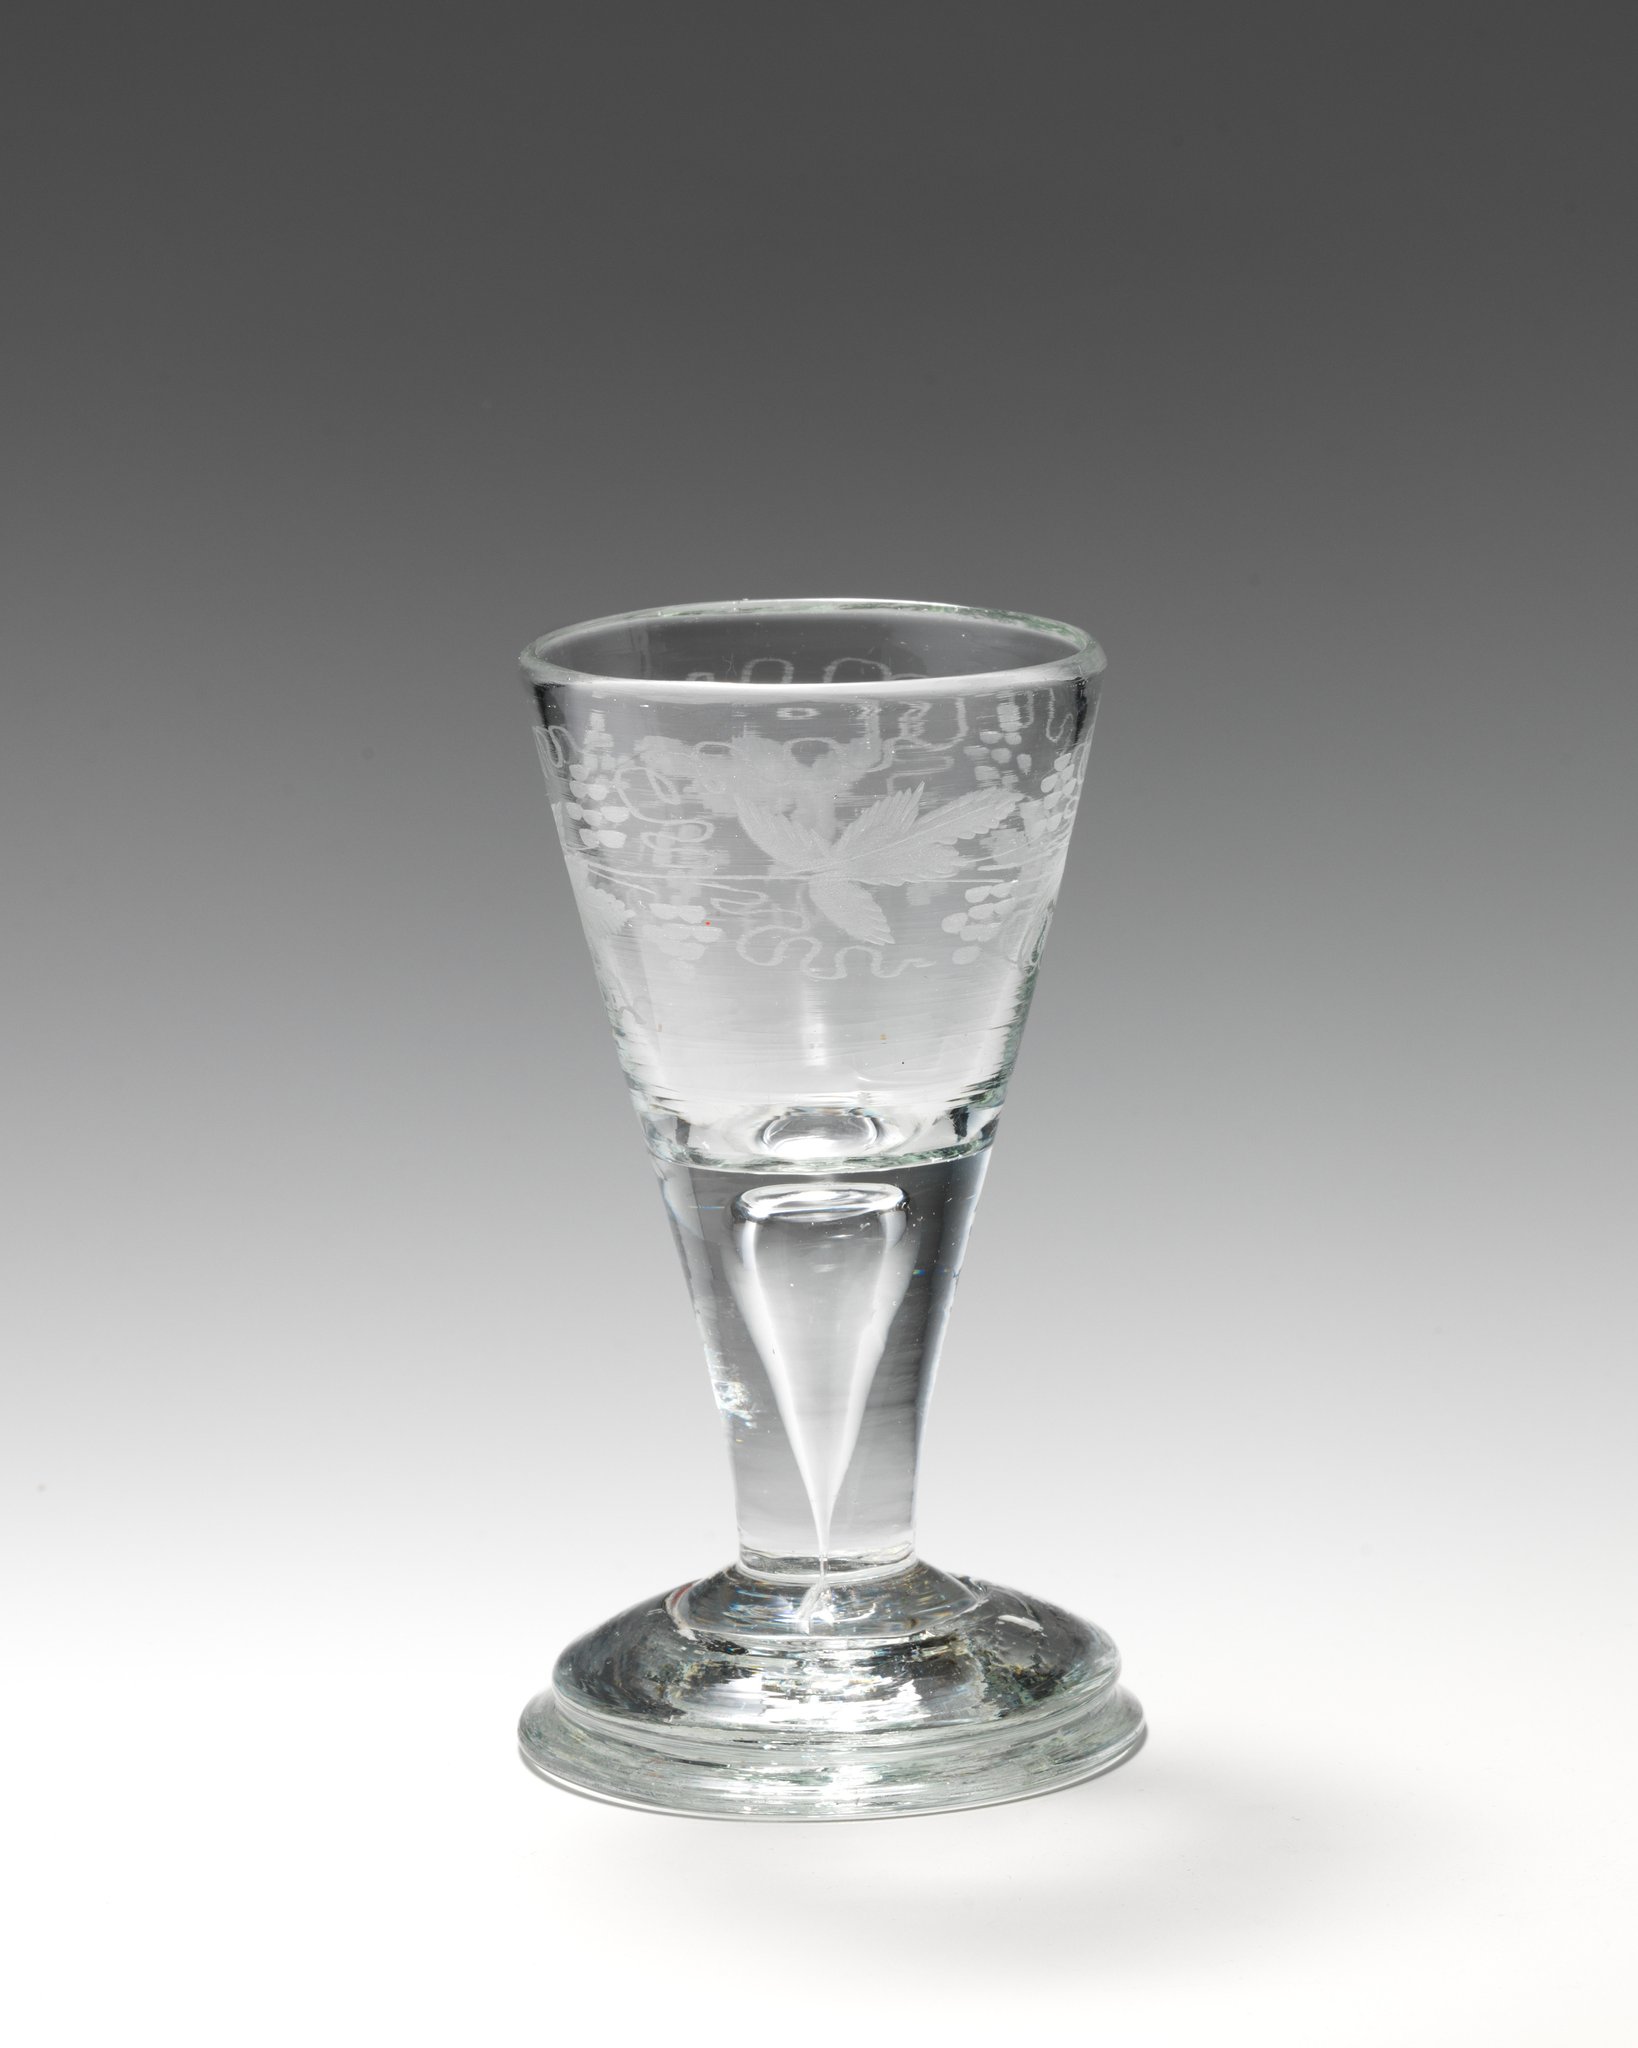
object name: wineglass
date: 1701-1800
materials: glass